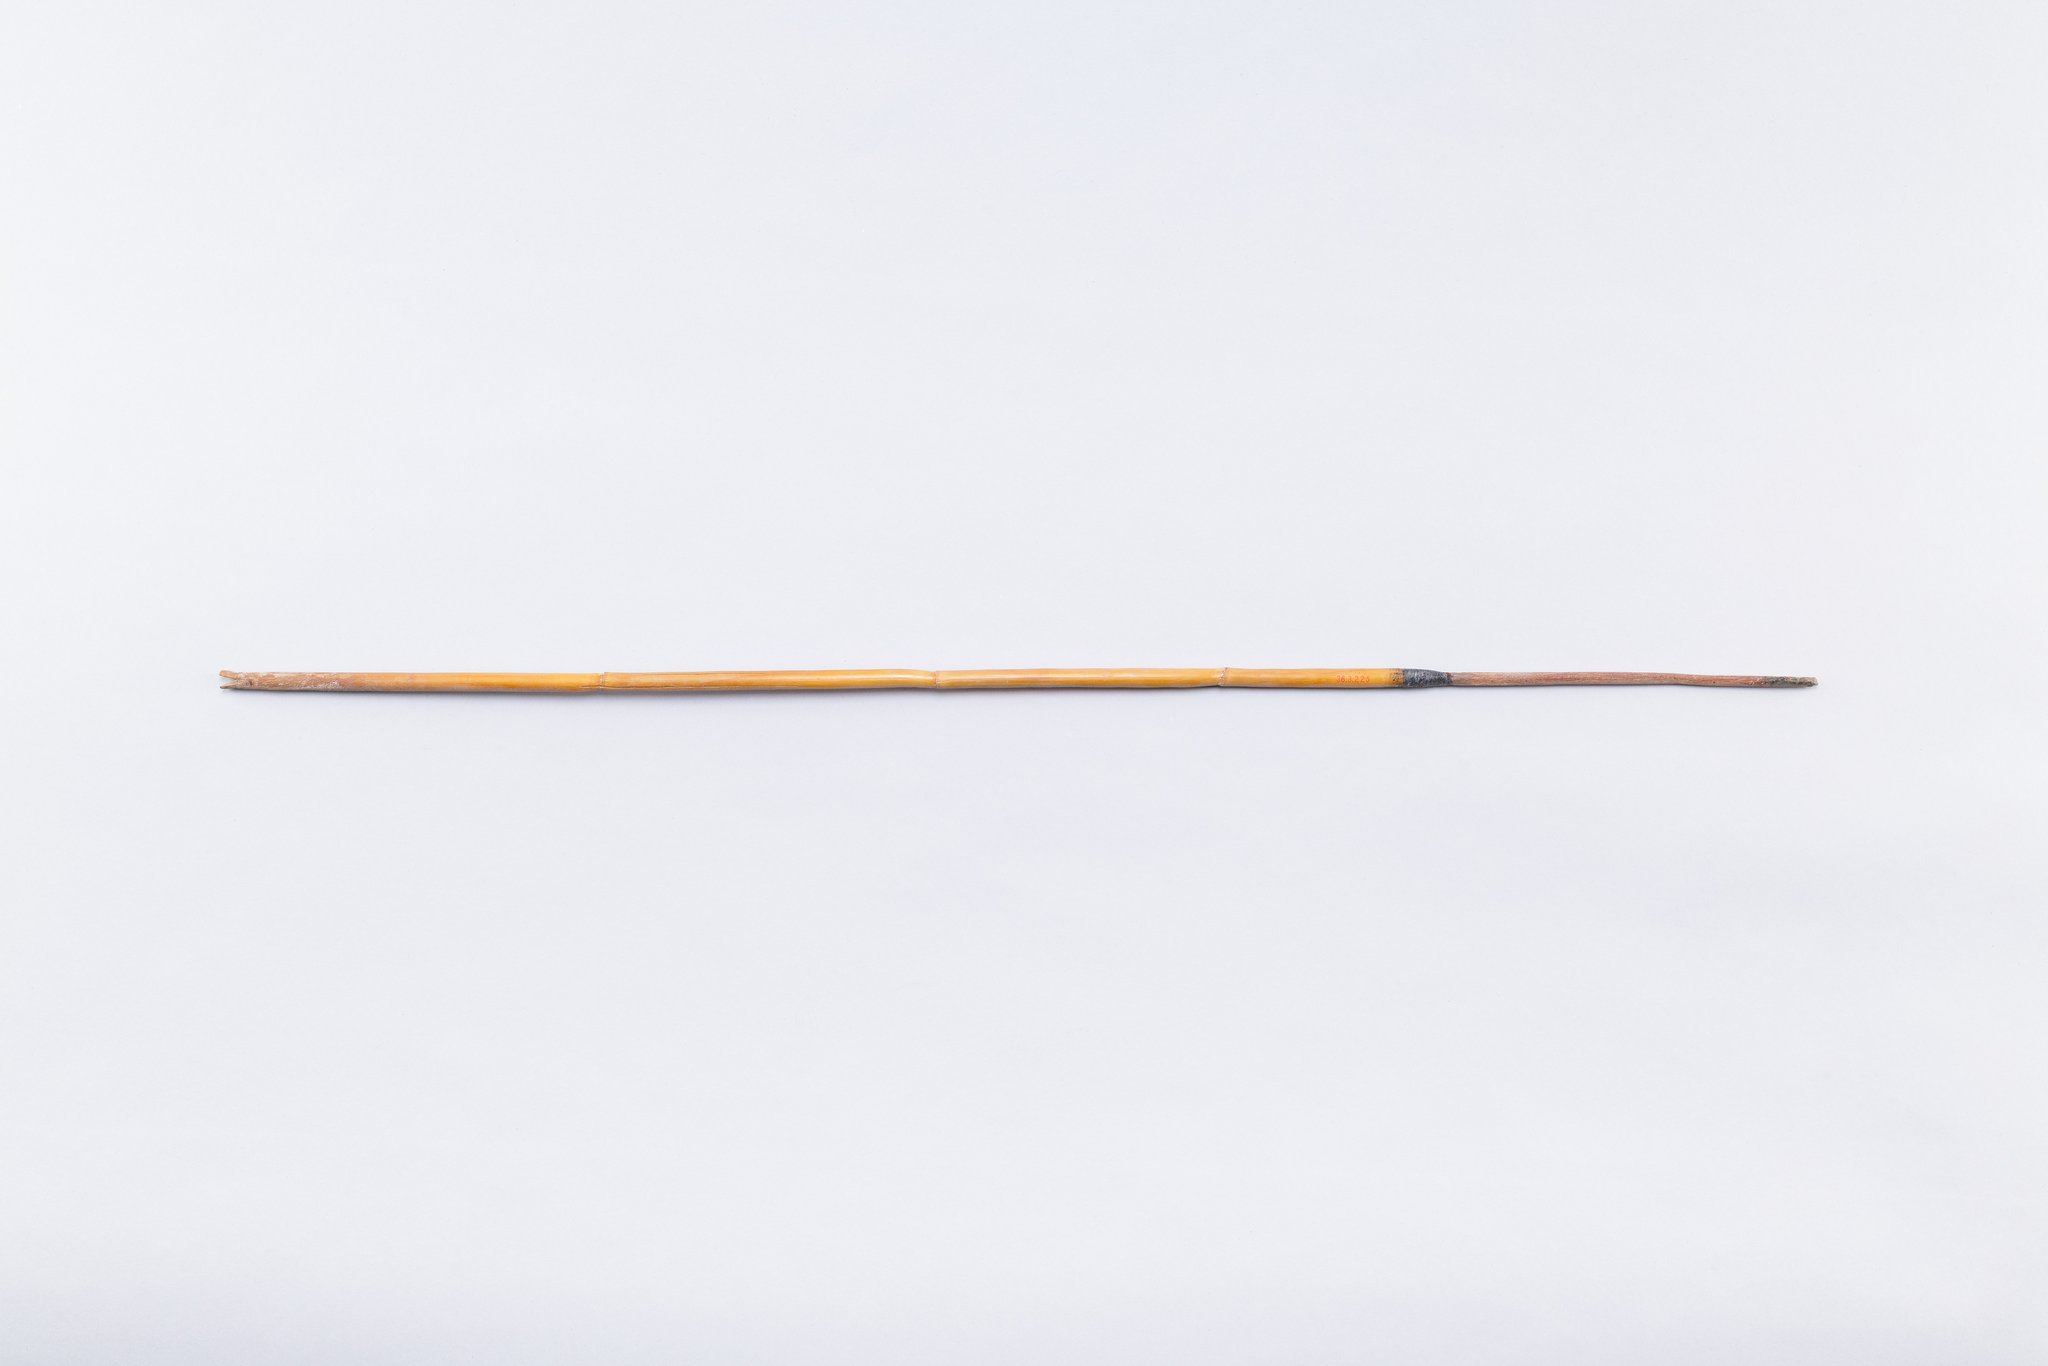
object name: arrow, arrowhead, adhesive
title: Arrow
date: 1479-1458 BCE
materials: quartz, wood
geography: egypt